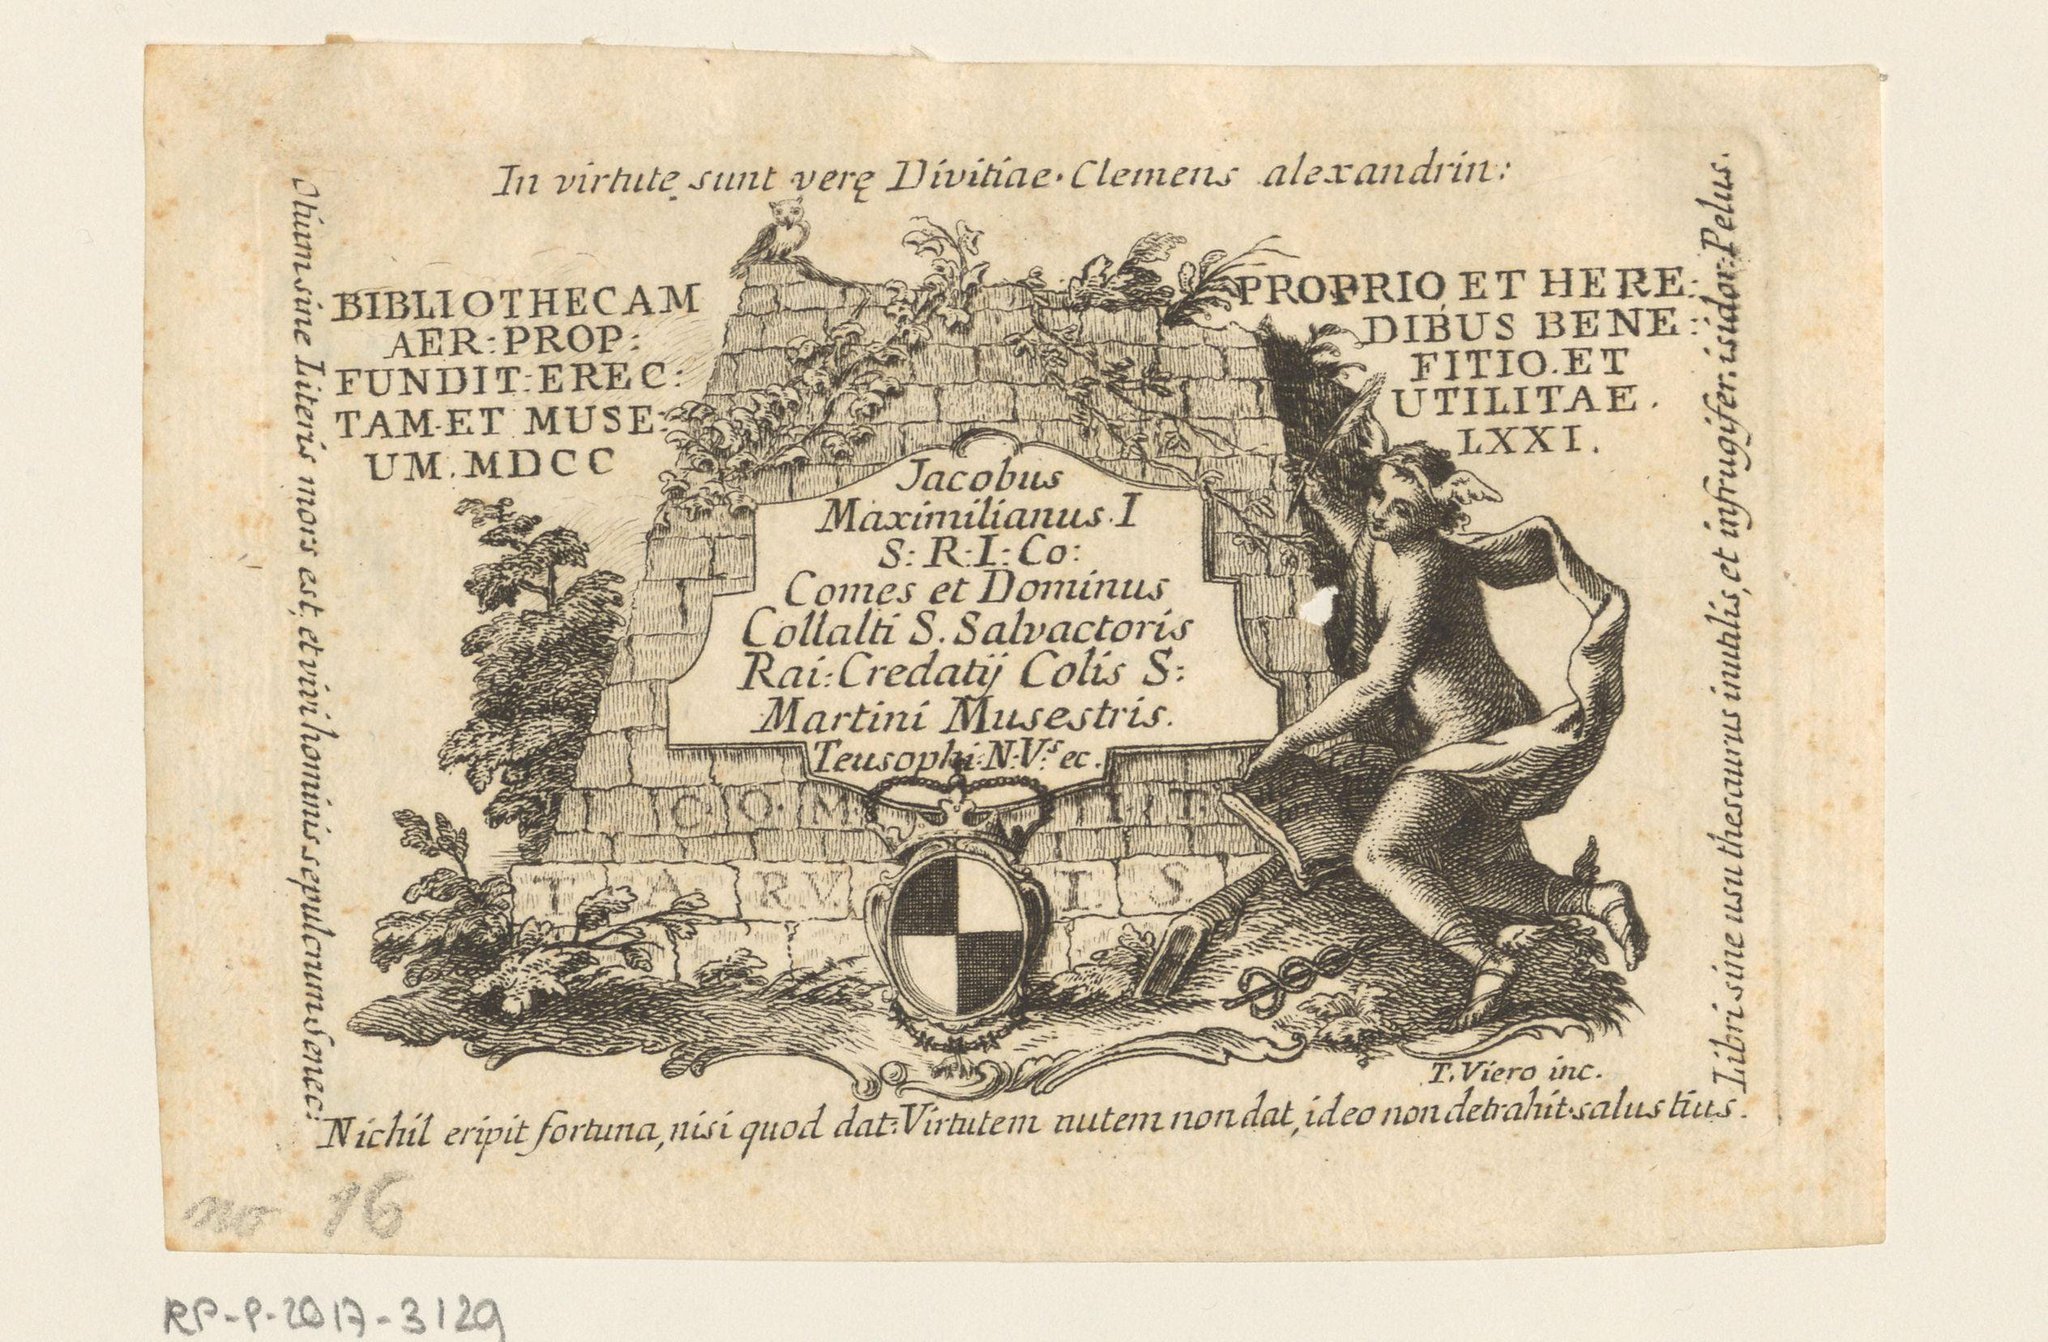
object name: bookplate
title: Otium sine Literis mors est, et vivi hominis sepulcrum. Senec: Nihil eripit fortuna, nisi quod dat: Virtutem autem non dat, ideo non detrahit salustius. Libri sine usu thesaurus inutilis, et infrugifer. isidor: Pelus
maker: teodoro viero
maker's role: draughtsman, print maker, publisher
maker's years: 1740-1819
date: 1771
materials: paper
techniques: etching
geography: venice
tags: quill, (story of) mercury (hermes), ruin of a building ~ architecture, armorial bearing, heraldry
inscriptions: inscription: ‘Collalto / Massimiliano [...] / 6.00’, inscription: ‘no 16’